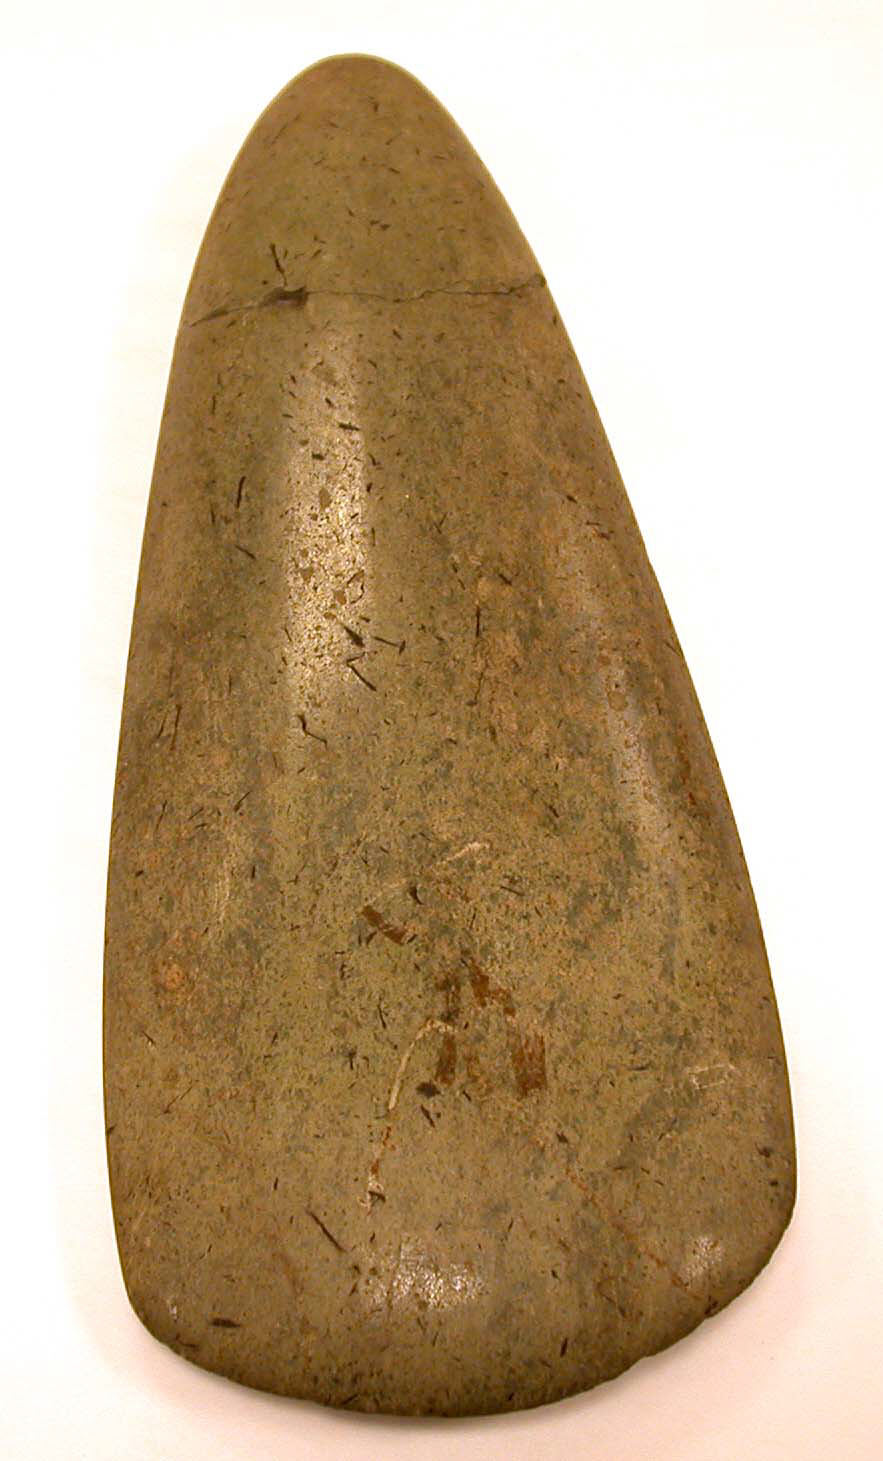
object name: celt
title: Stone Celt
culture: mexican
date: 1501-1600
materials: stone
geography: mexico